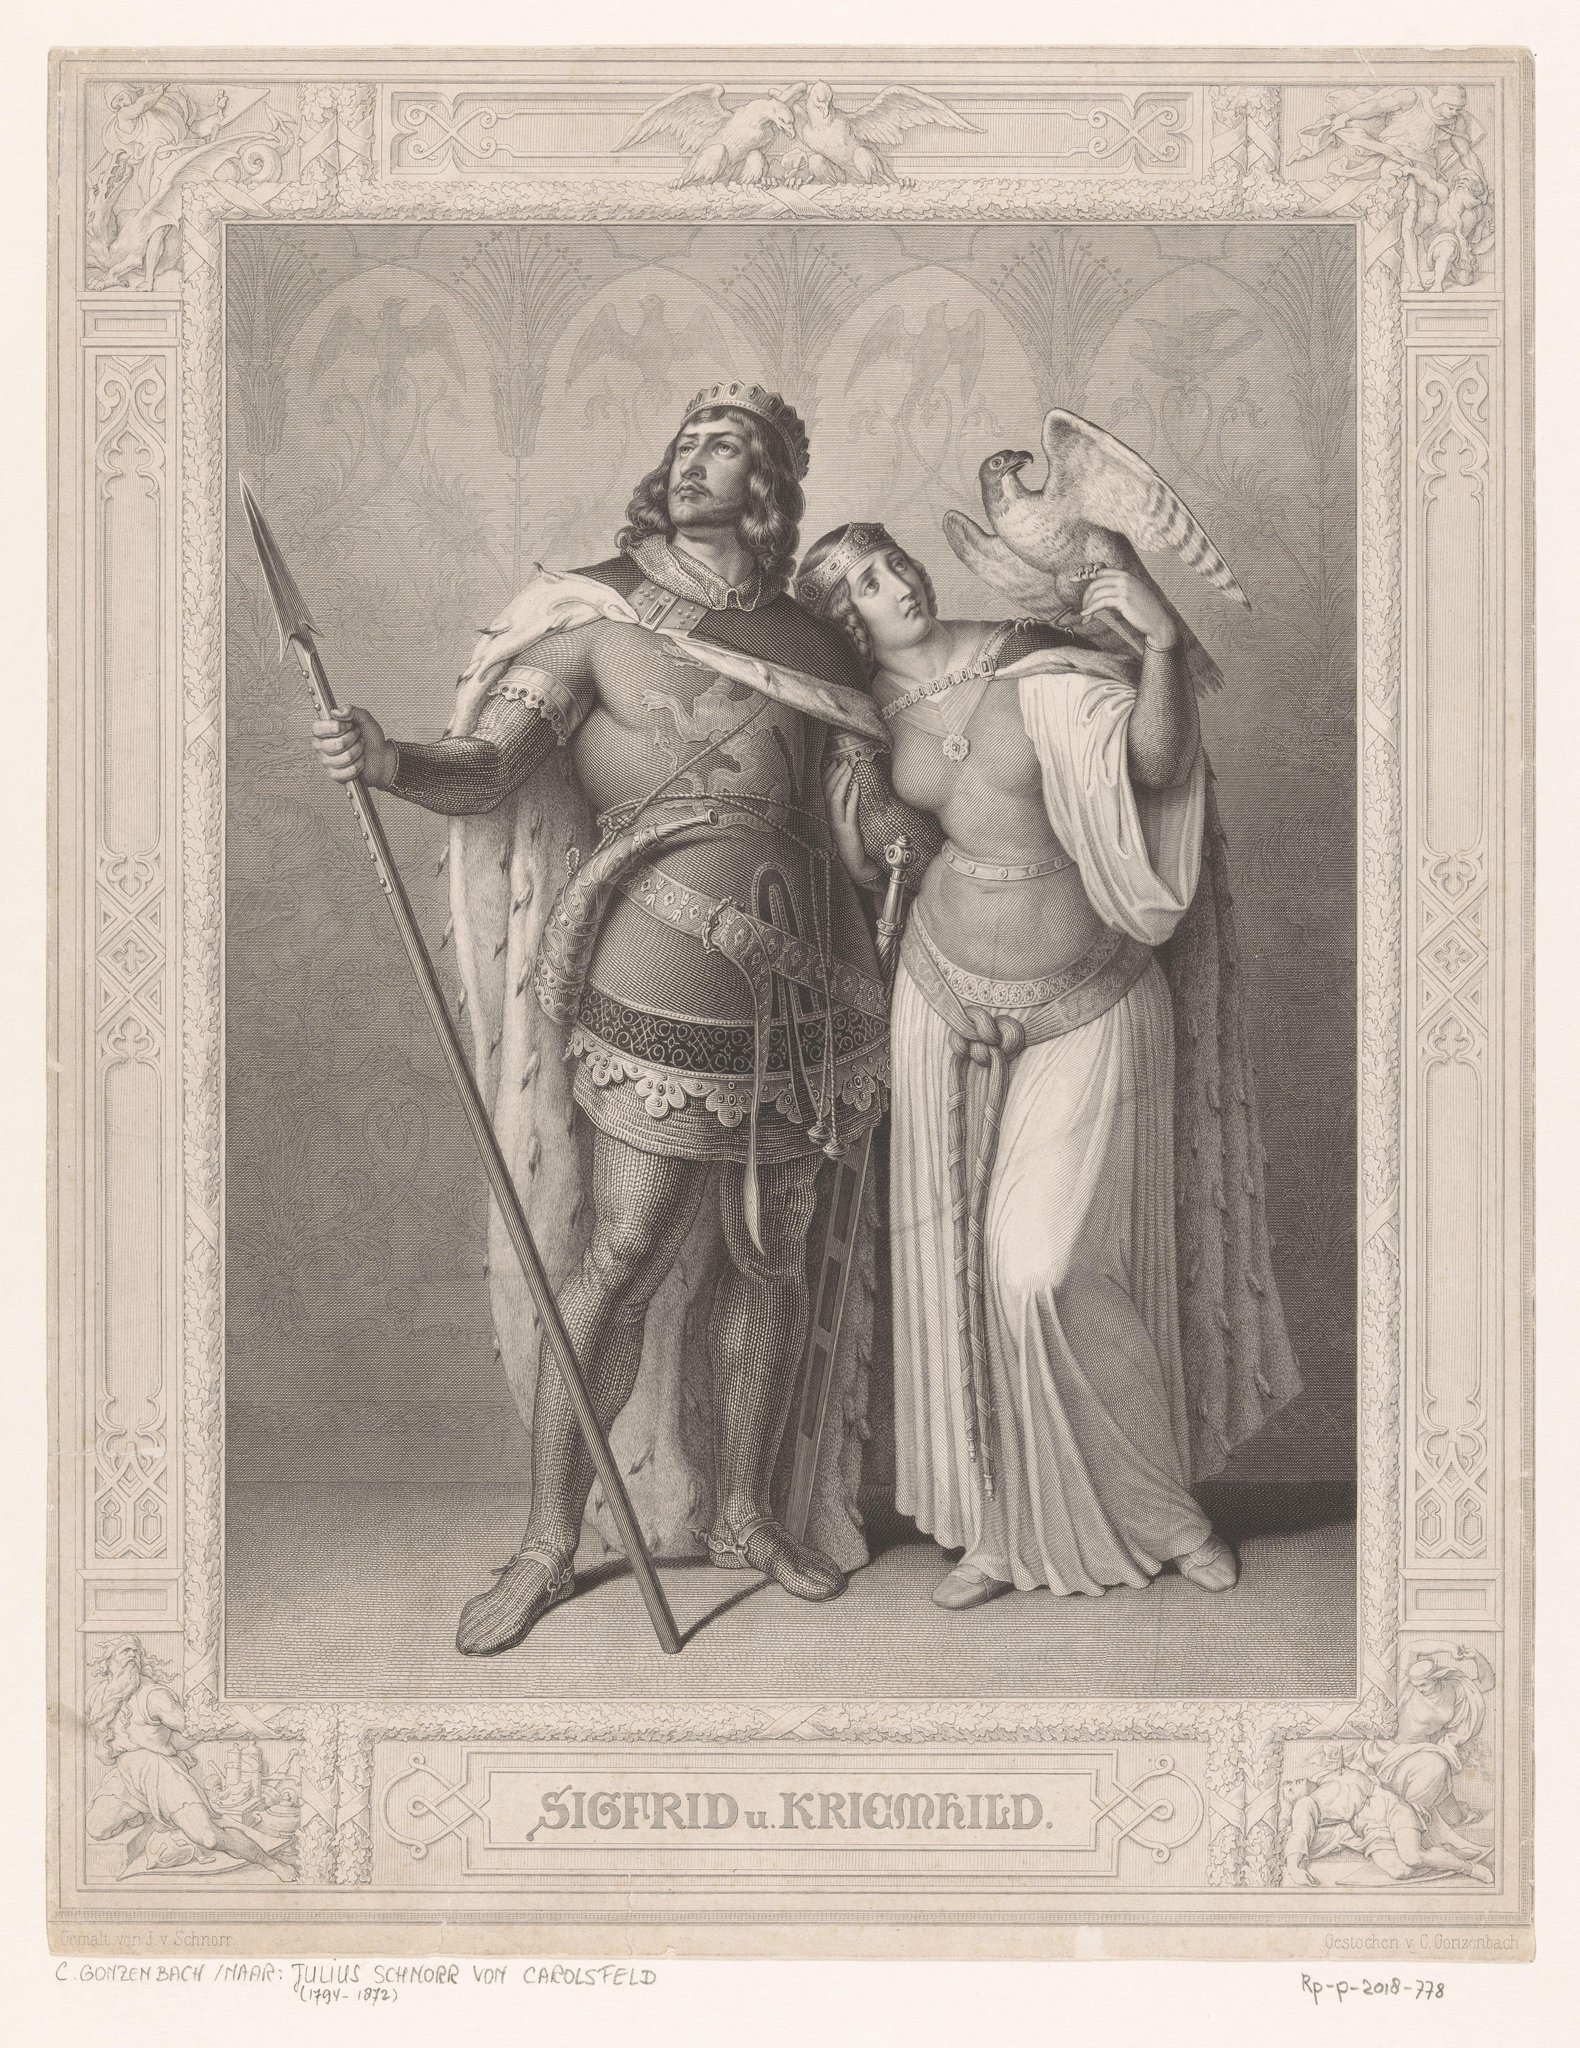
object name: print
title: Sigfrid und Kriemhild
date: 1860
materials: paper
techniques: engraving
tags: siegfried, 'nibelungenlied' : use 81(nibelungenlied), female literary characters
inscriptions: collector's mark: Lugt 2228